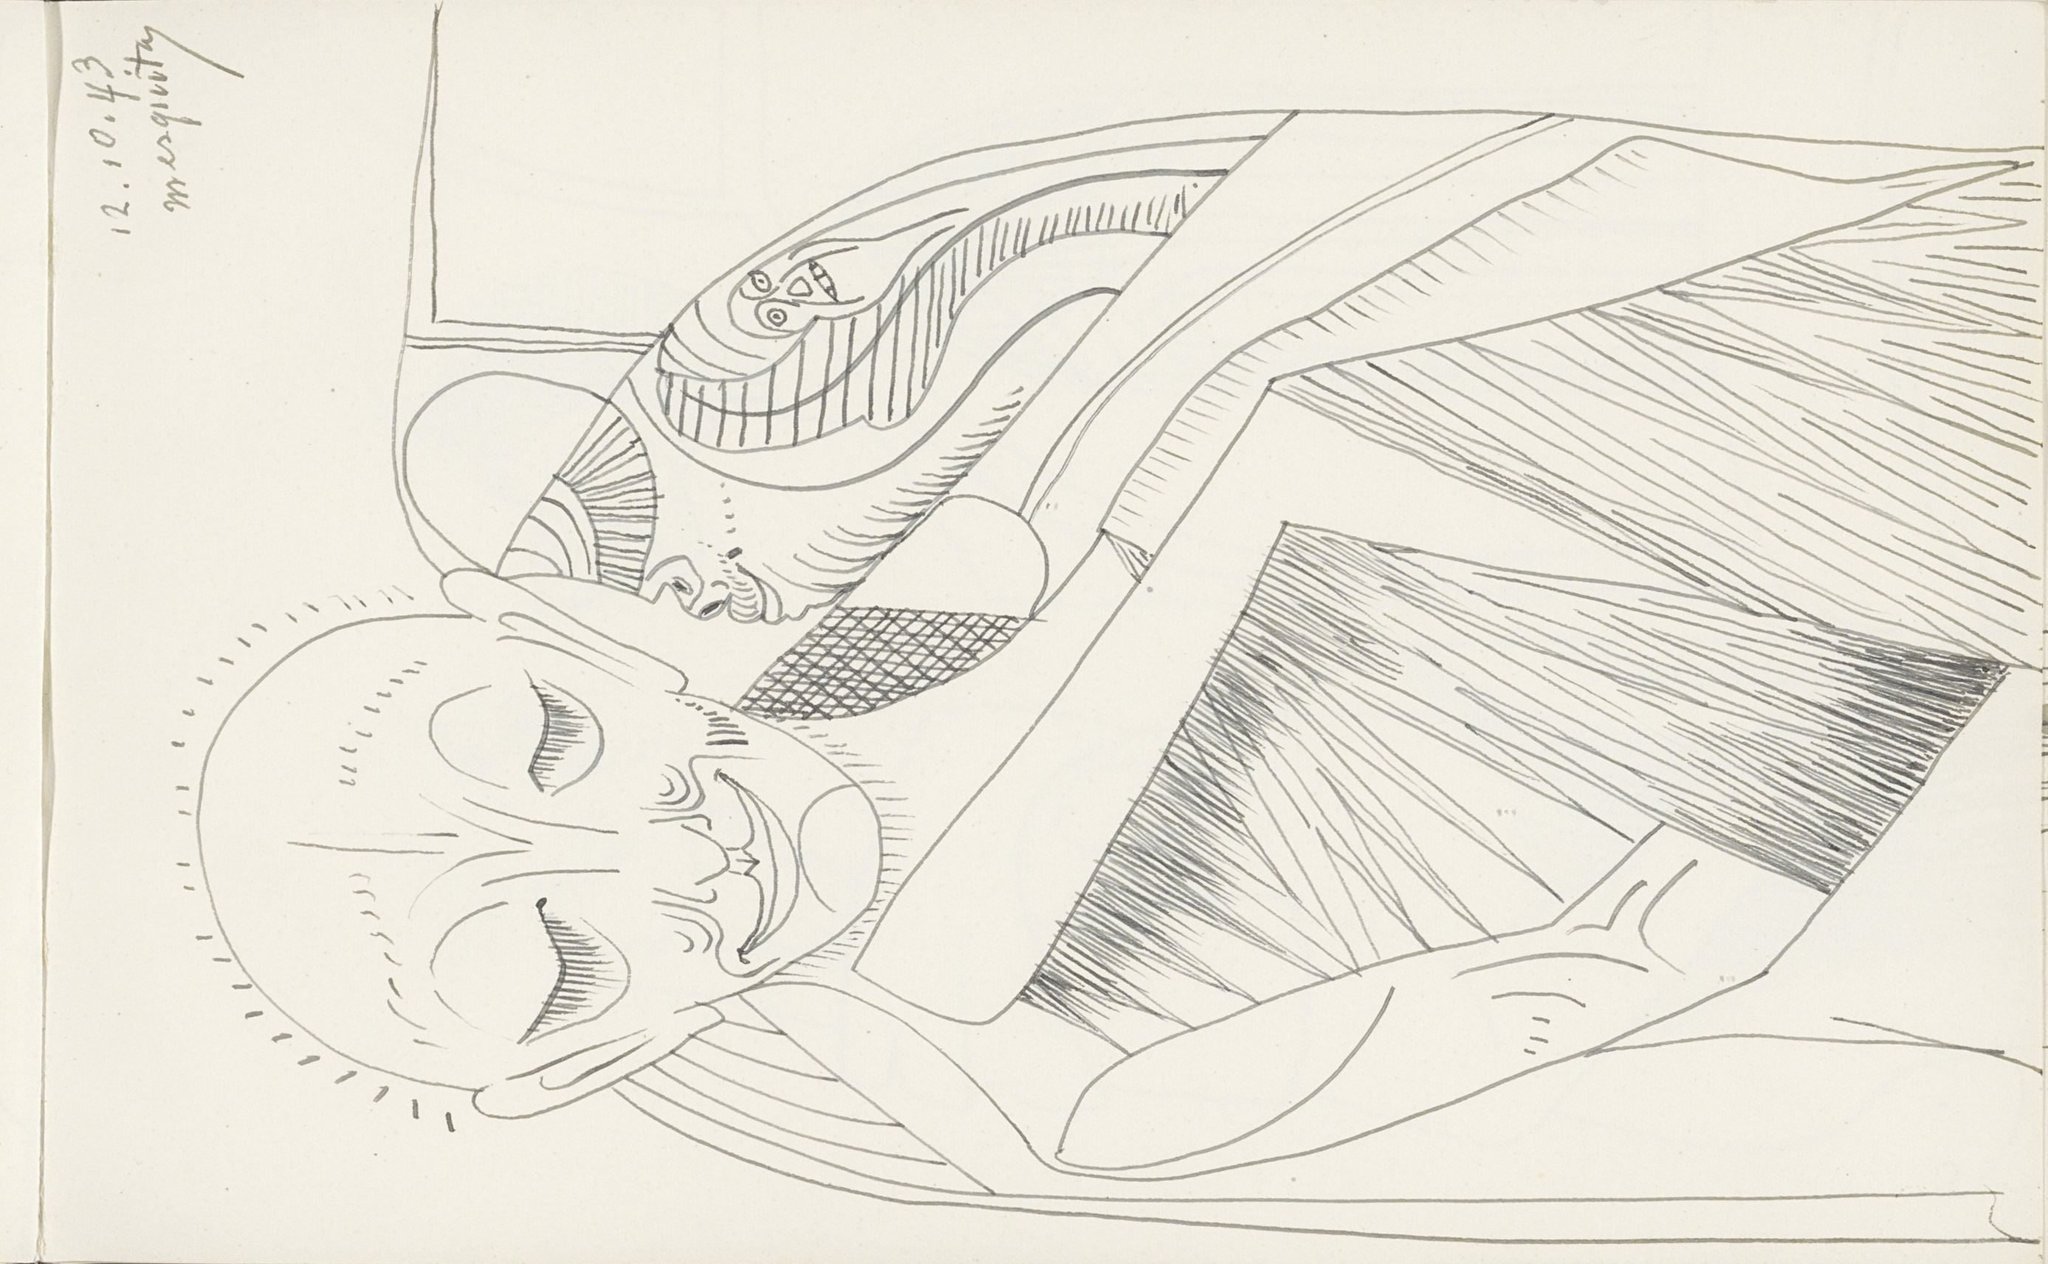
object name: sketchbook leaf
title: Man met gesloten ogen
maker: samuel jessurun de mesquita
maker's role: draughtsman, print maker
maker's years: 1868-1944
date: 1943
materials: ink, paper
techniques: pen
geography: amsterdam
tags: adult man, head-gear: hat (+ men's clothes), surrealia, surrealistic representations, eyes closed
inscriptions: signature and date: ‘12.10.43/ mesquita’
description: In profiel een fantasiefiguur met een baard en punthoed en een derde fantasiefiguur van voren gezien. Blad 6 recto uit een schetsboek met 18 bladen.